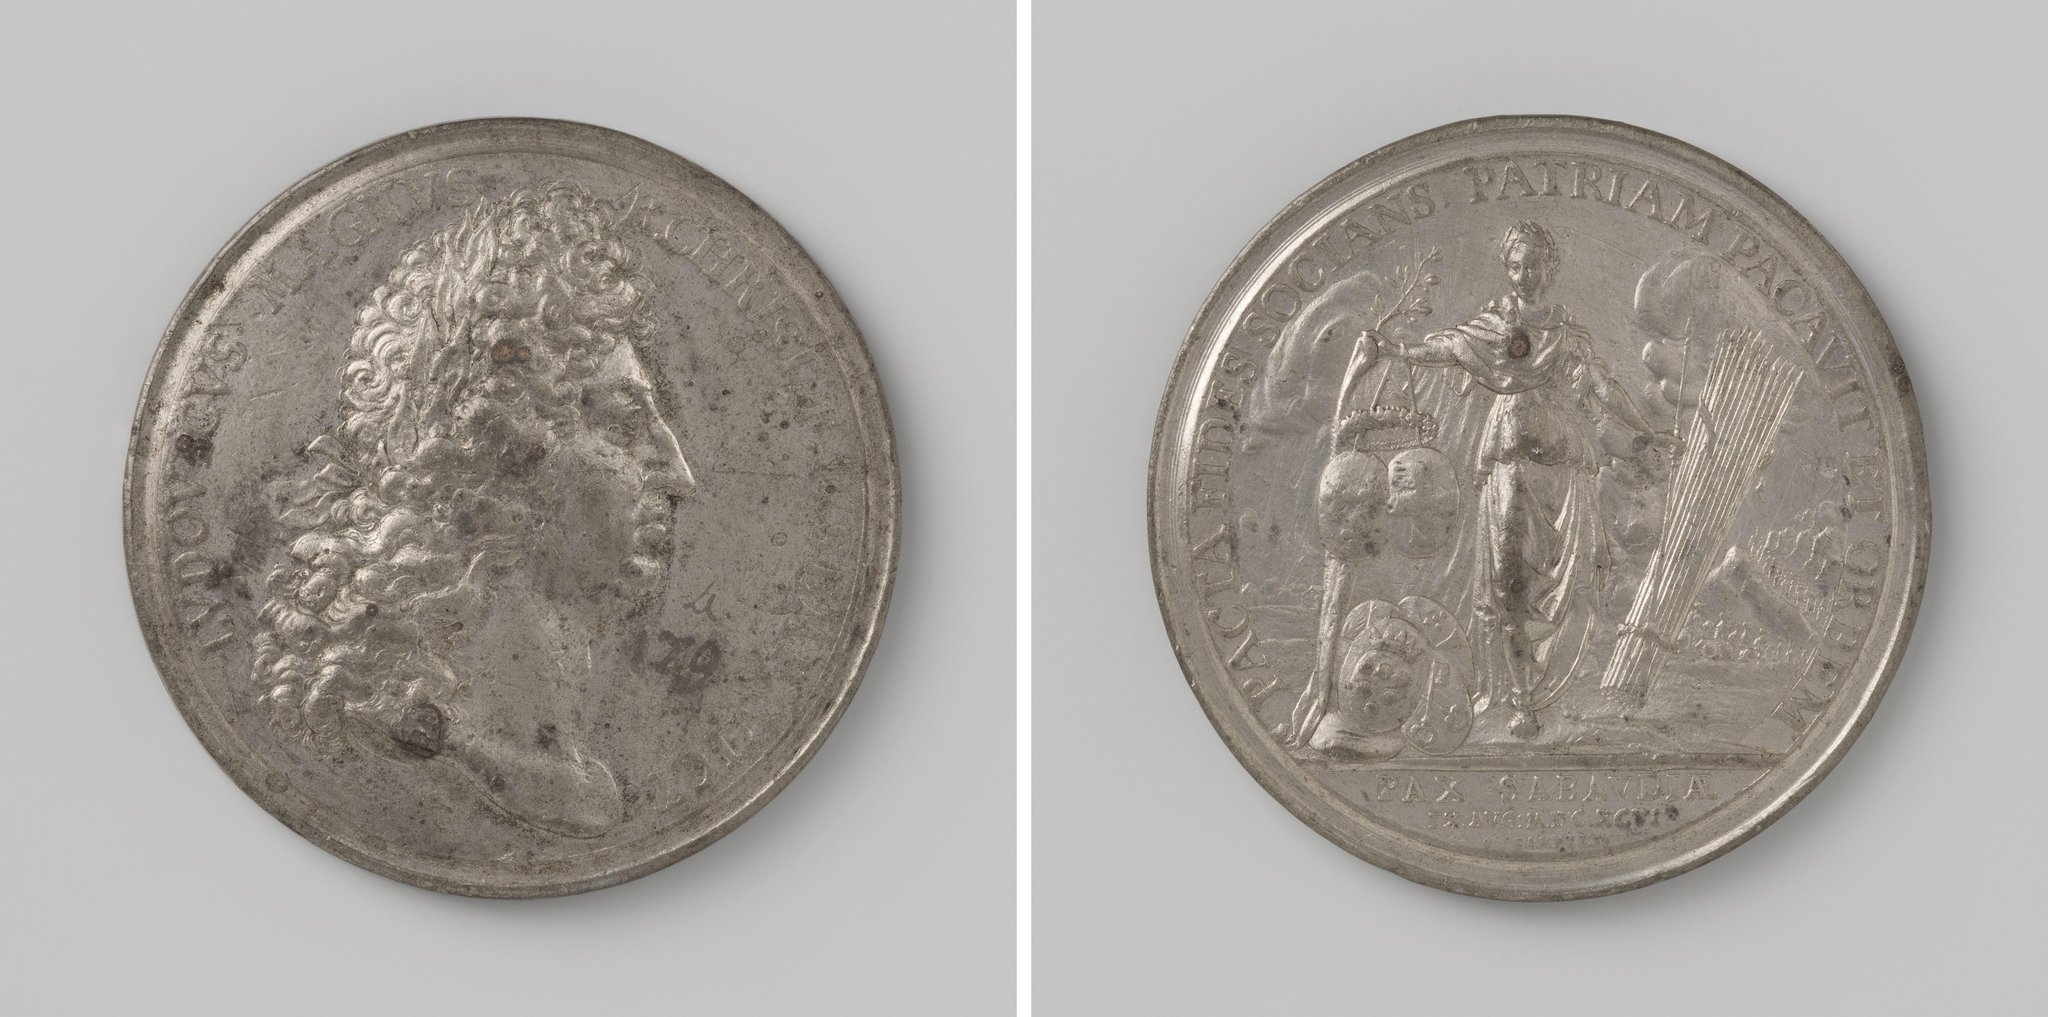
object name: history medal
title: Vrede tussen Frankrijk en Savoye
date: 1696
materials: silver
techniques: striking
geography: paris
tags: lodewijk xiv (koning van frankrijk), france